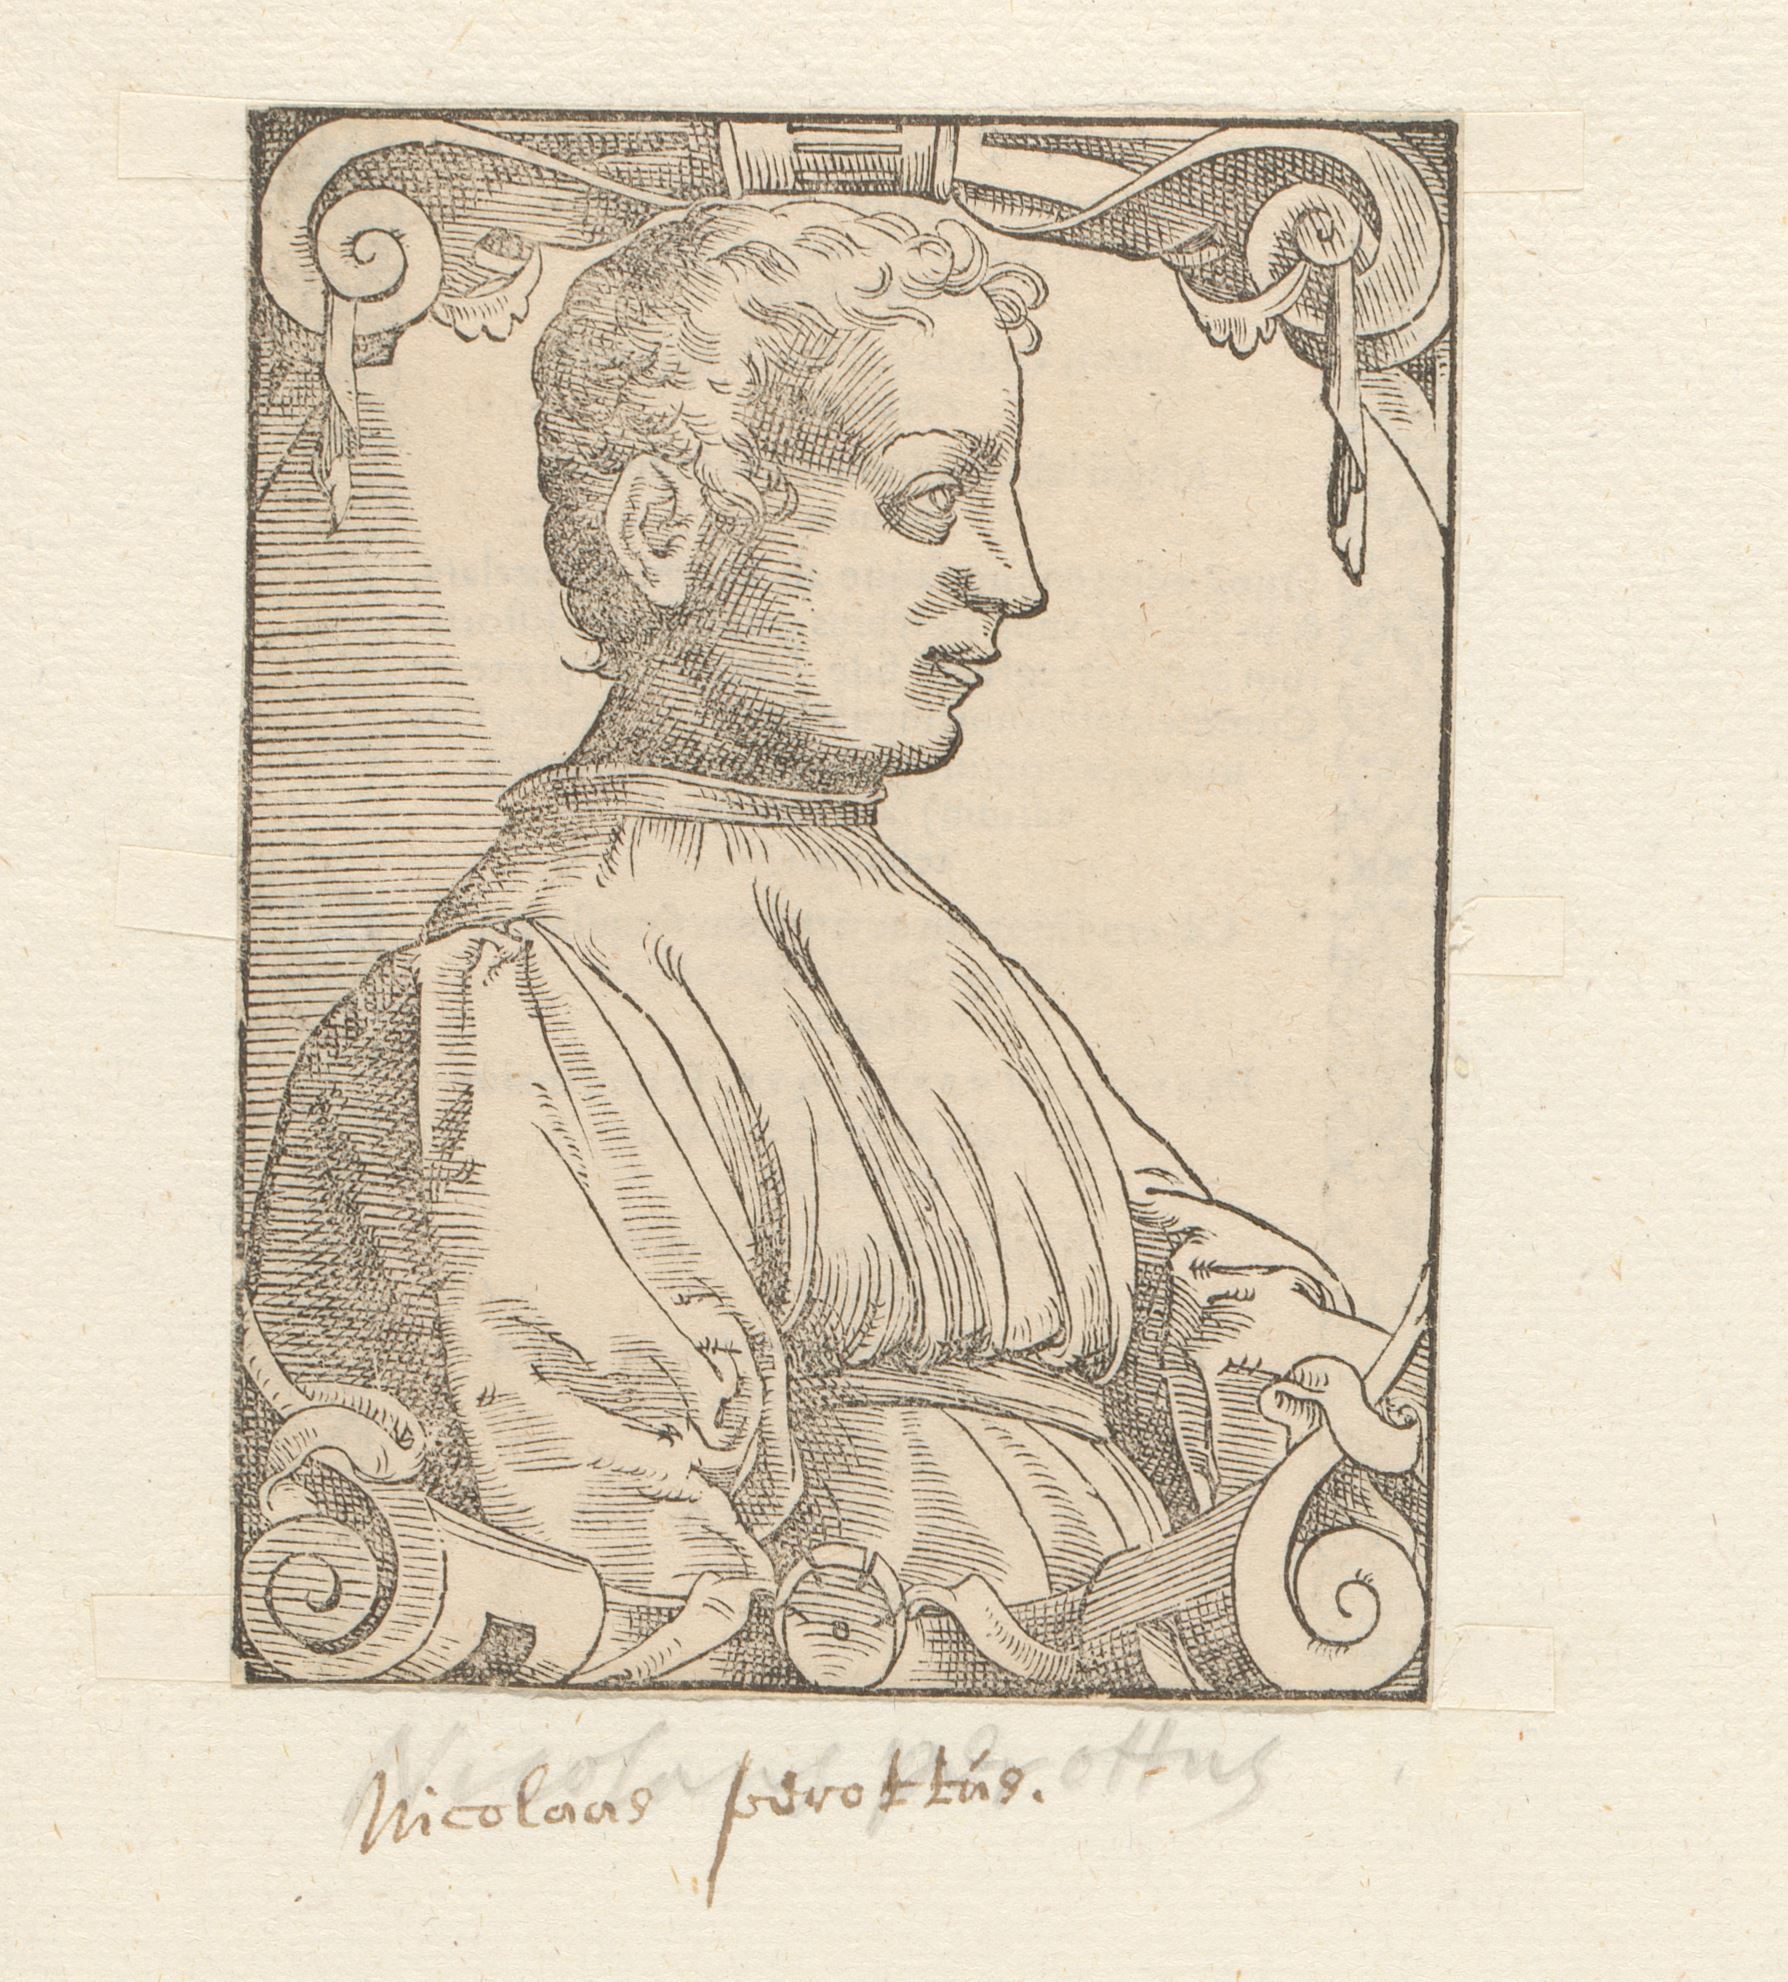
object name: album leaf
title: Portret van Niccolò Perotti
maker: Anonymous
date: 1549-1577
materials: paper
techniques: letterpress printing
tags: philology (+ portrait of scholar, scientist), historical persons, portrait of a writer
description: Prent gebruikt in: Giovio, Paolo. Elogia Virorum literis illustrium (...). Bazel: Peter Perna, 1577.